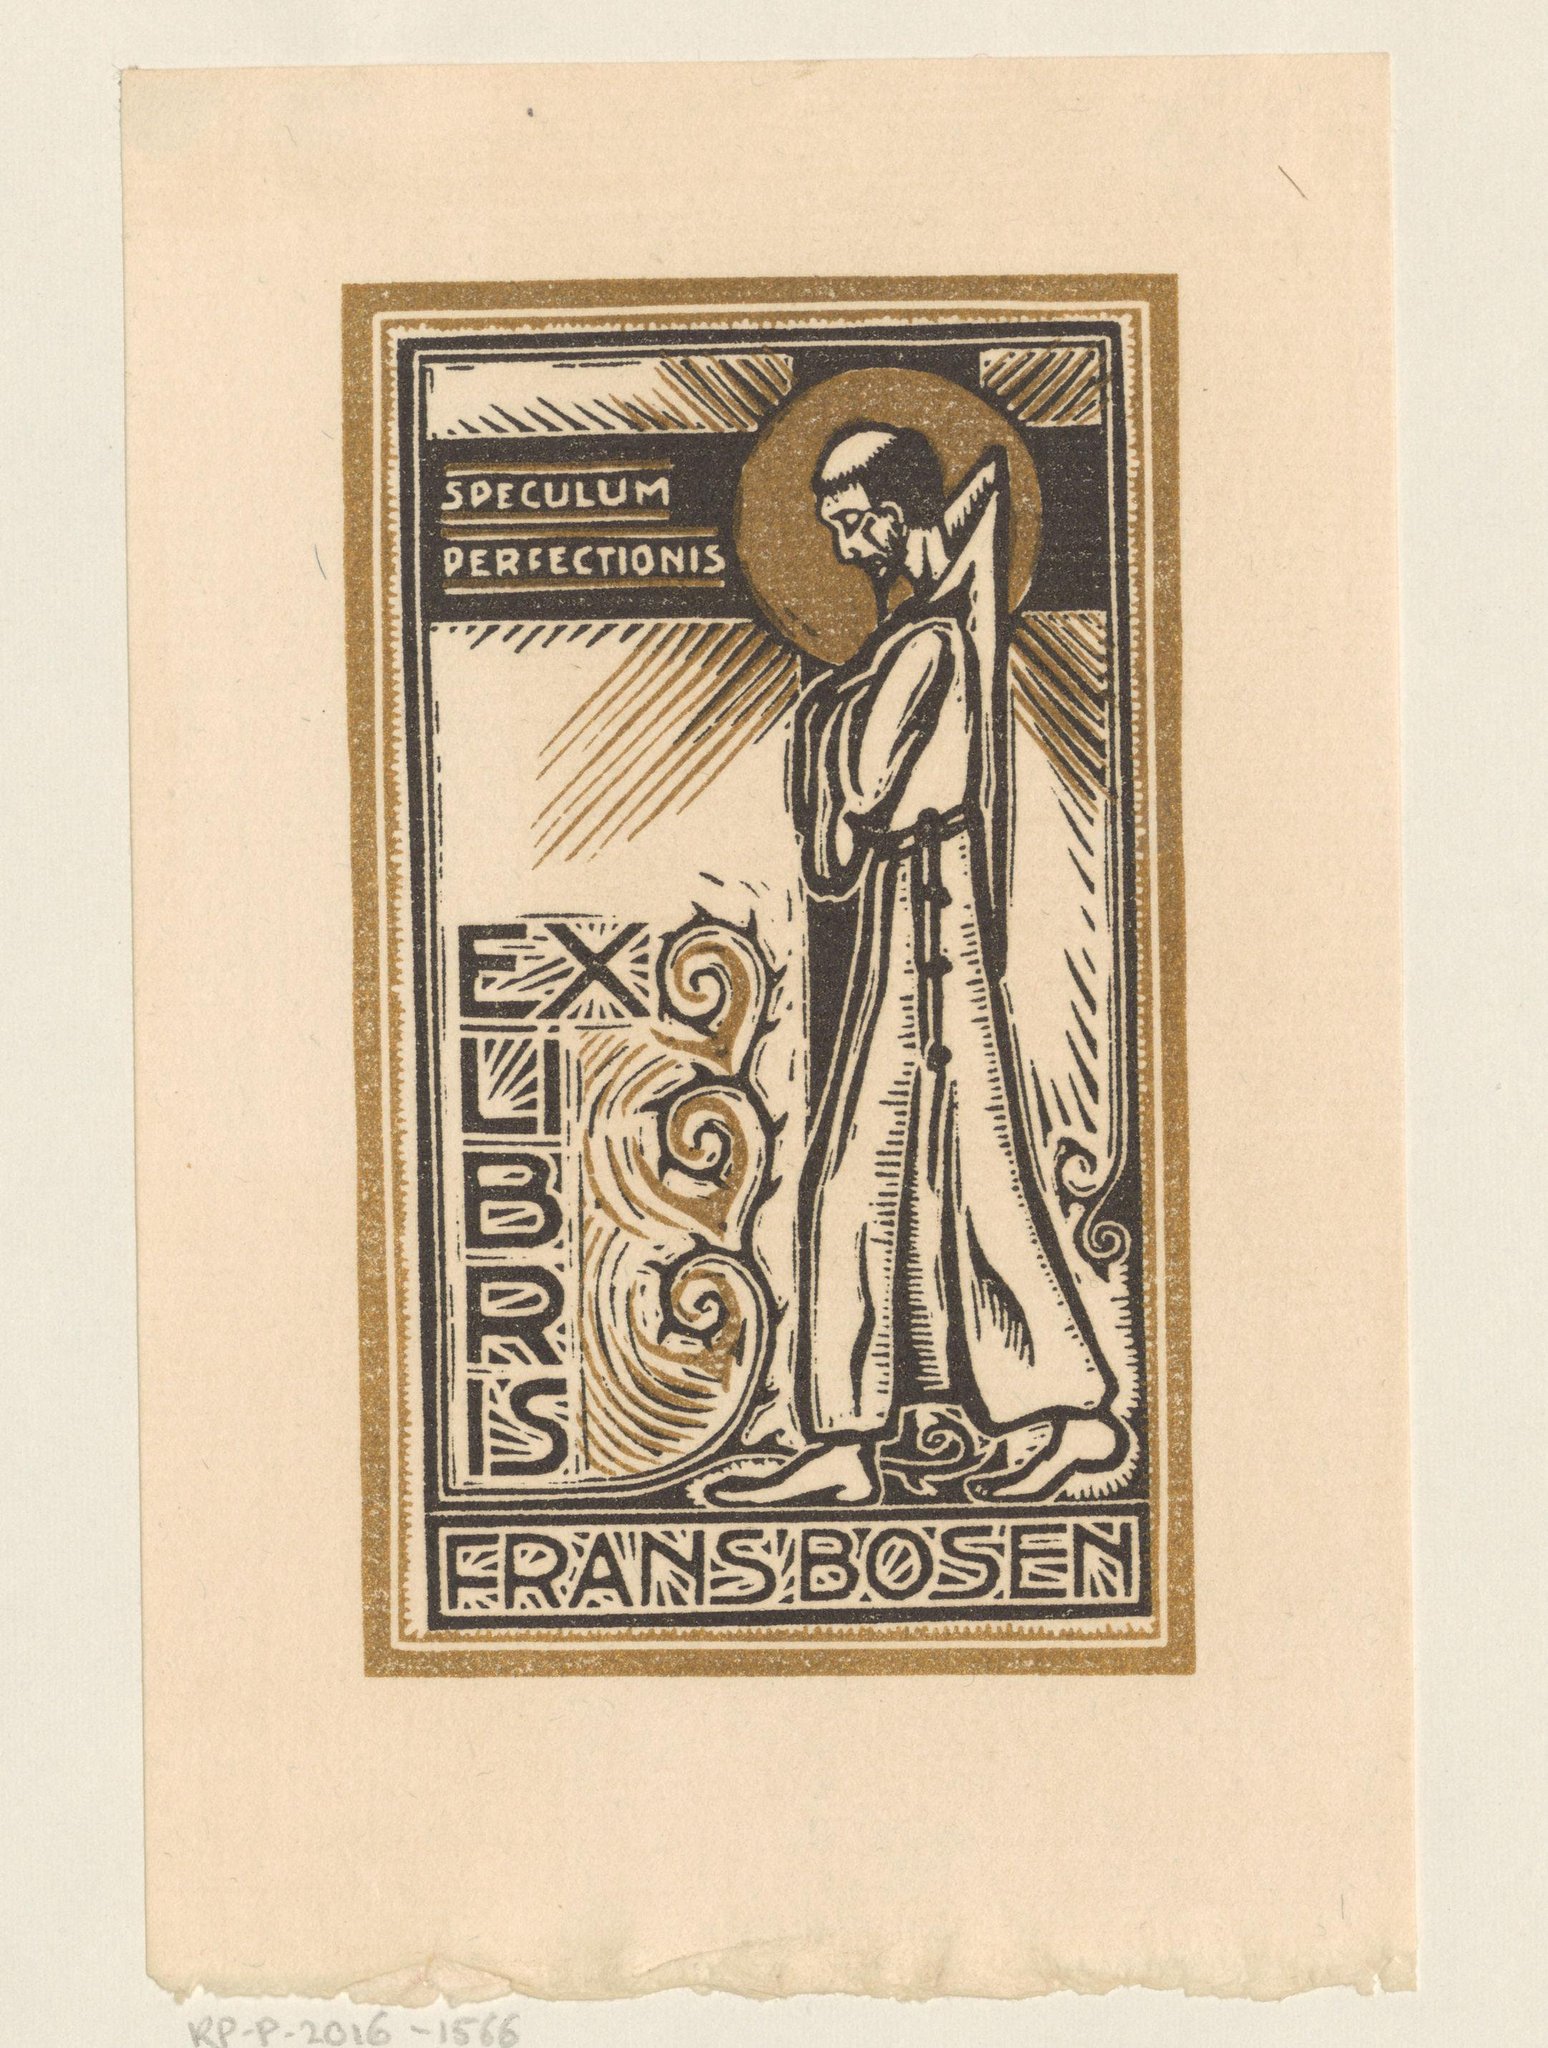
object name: bookplate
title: Speculum perfectionis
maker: frans bosen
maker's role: print maker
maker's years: 1891-1949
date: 1928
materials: paper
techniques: linocut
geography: netherlands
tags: frans bosen, monk(s), friar(s)